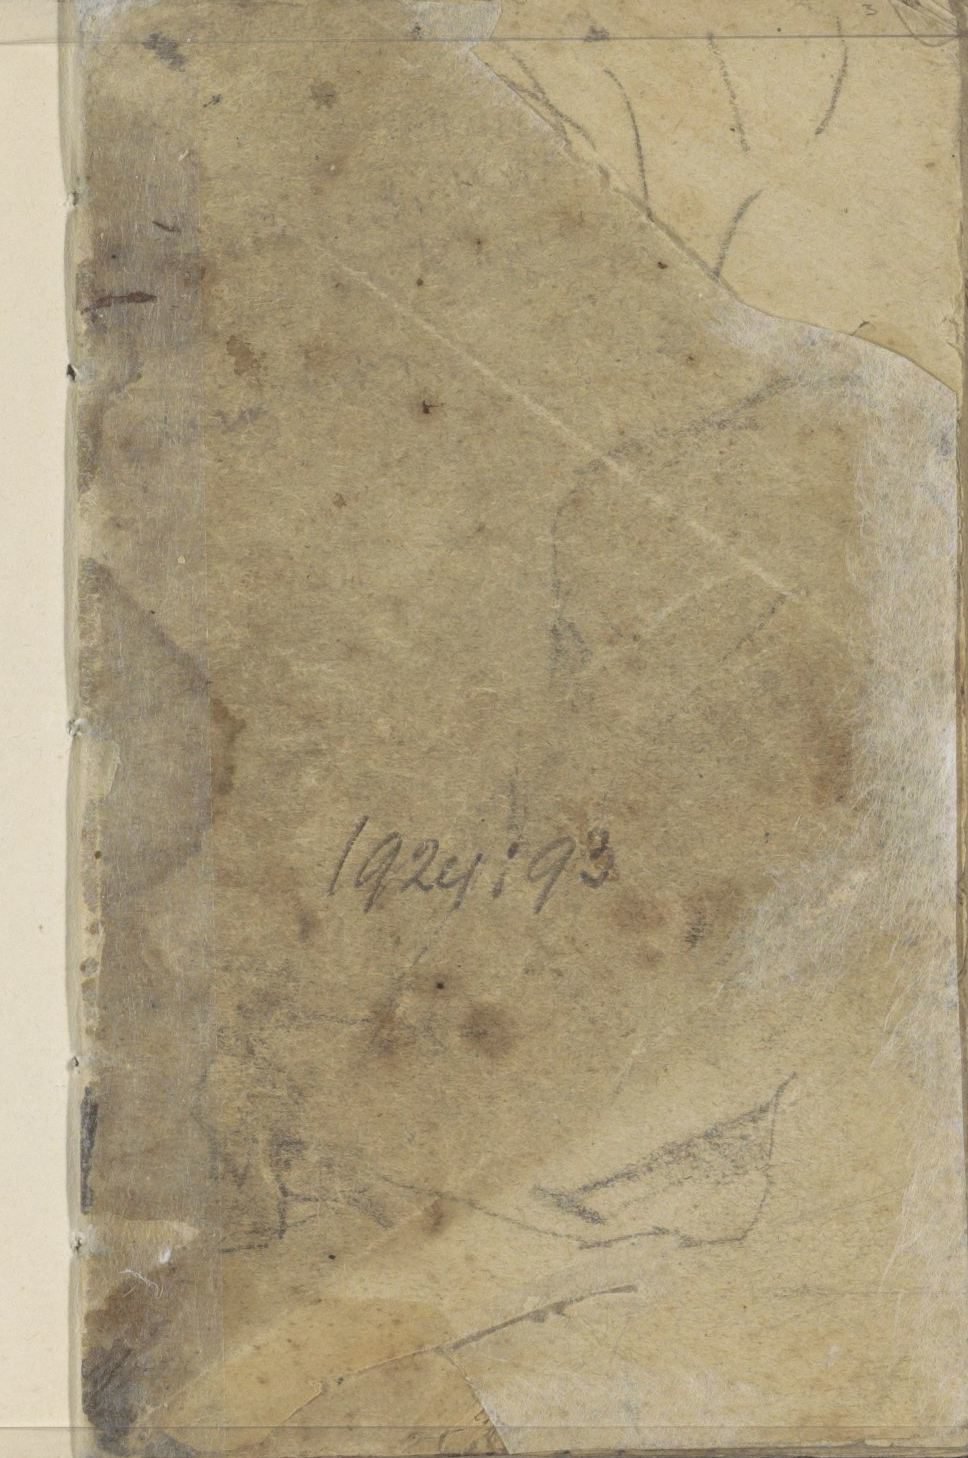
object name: sketchbook leaf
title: Studie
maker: george hendrik breitner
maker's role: draughtsman, painter, print maker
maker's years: 1857-1923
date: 1881-1883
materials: chalk, paper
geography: south holland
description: Studie. Pagina 1 uit een schetsboek met 43 bladen.